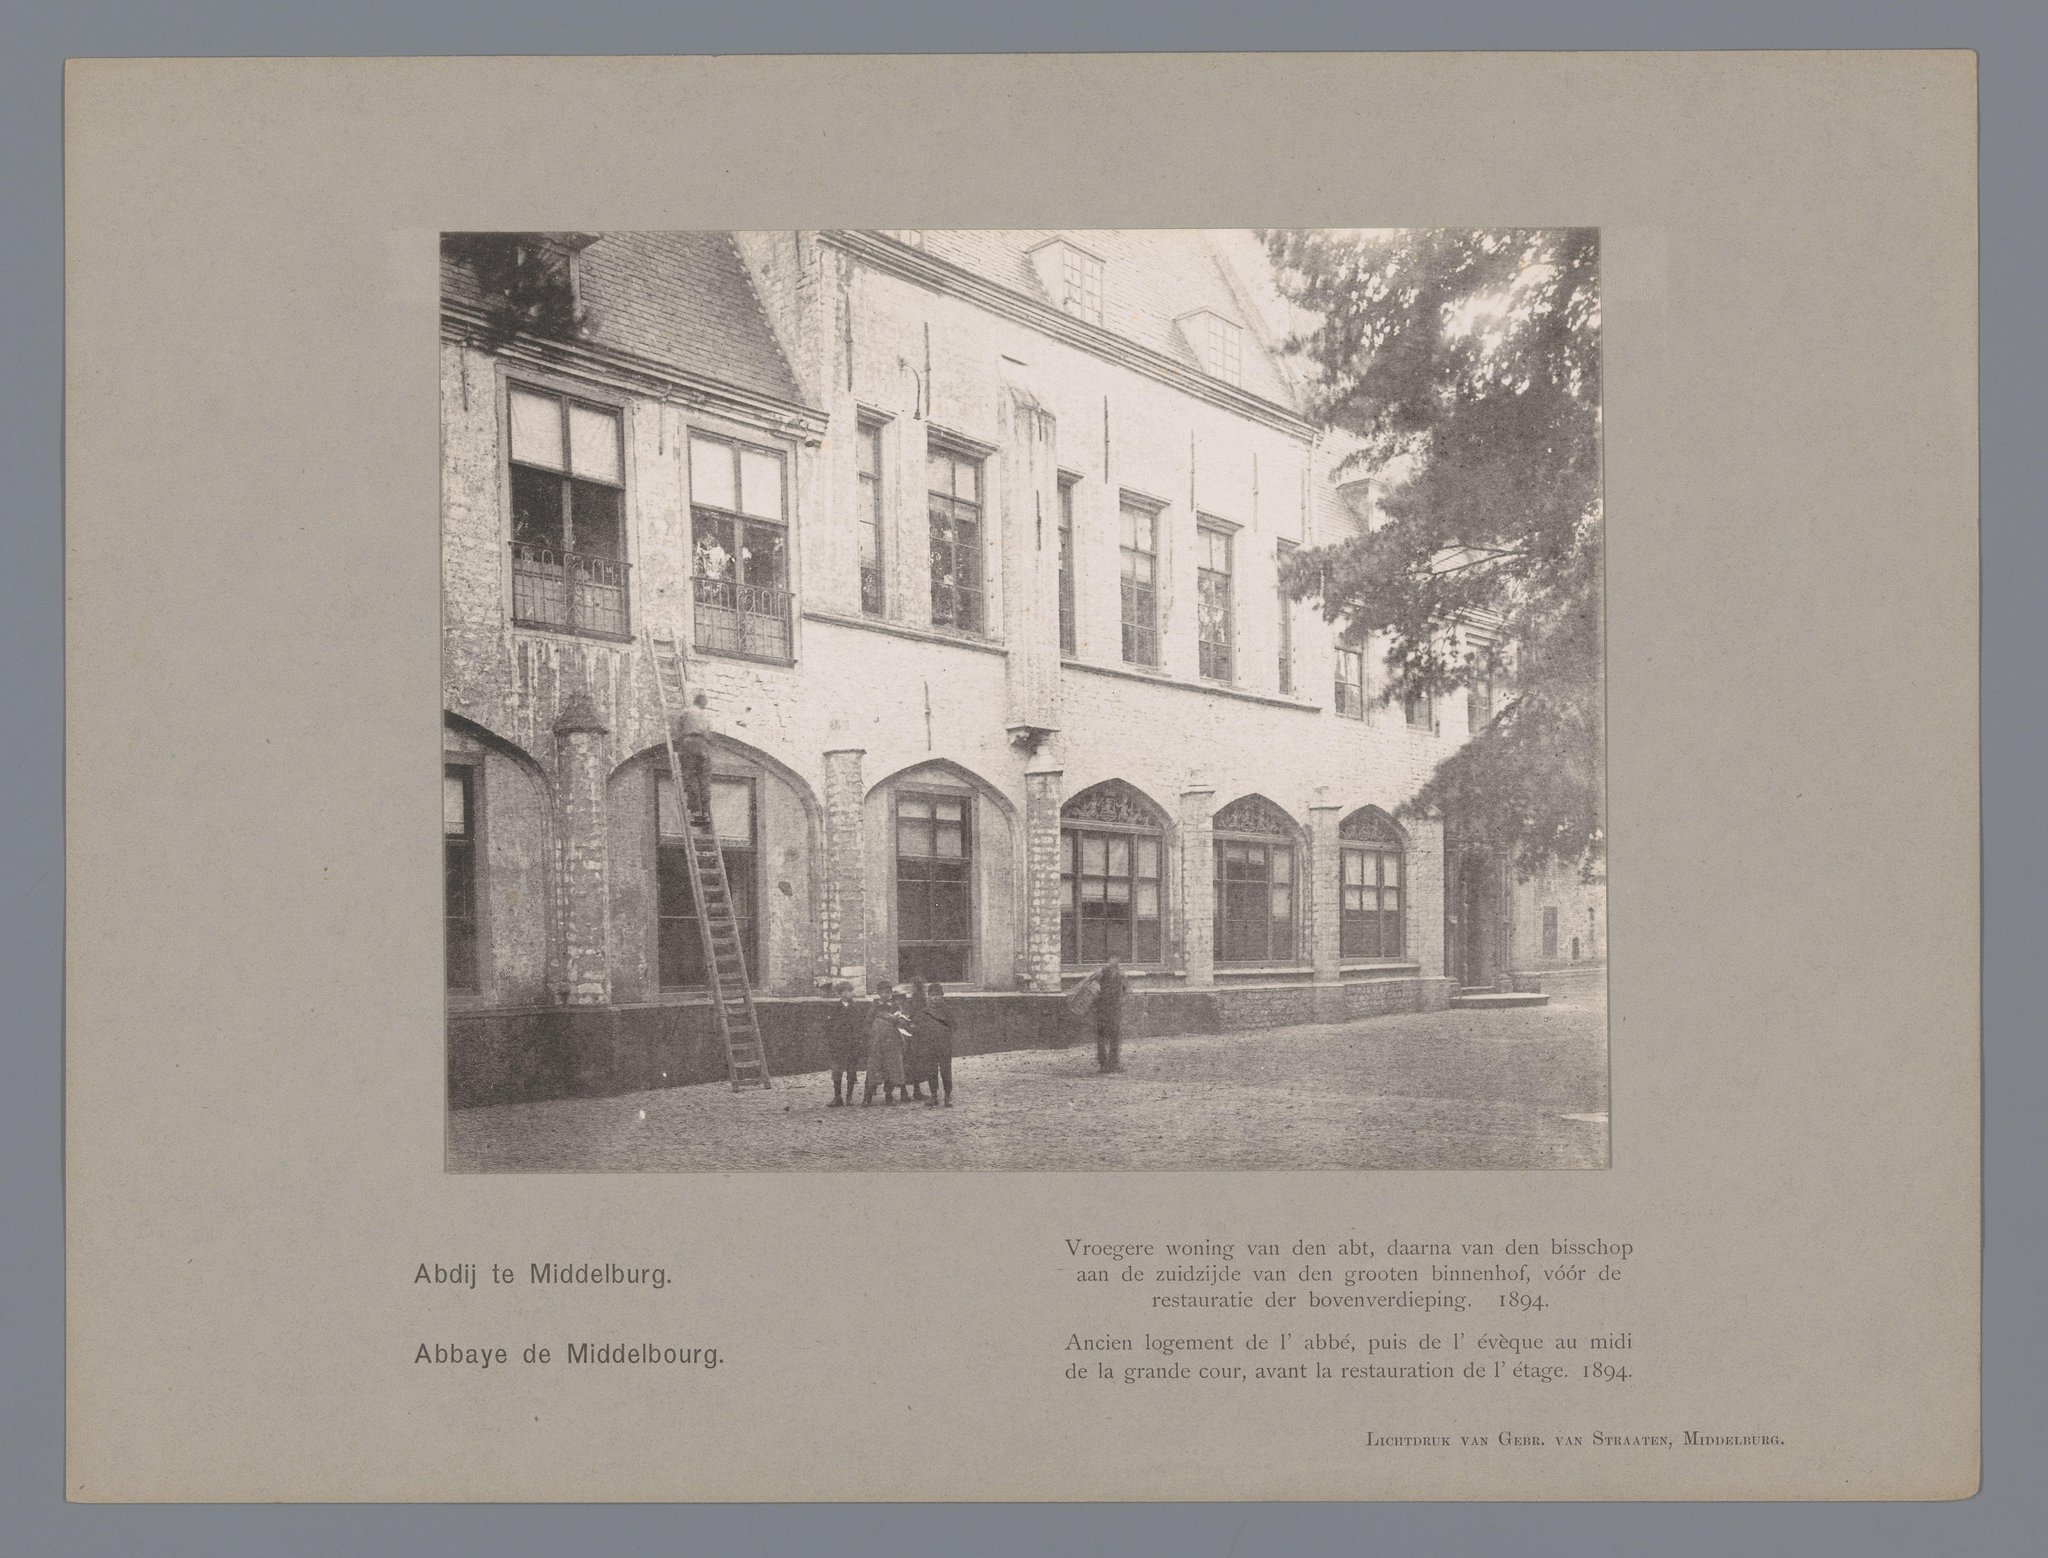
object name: photomechanical print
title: Gezichten op de Abdij te Middelburg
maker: Anonymous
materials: paper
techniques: photograph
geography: middelburg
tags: abbey, monastery, convent ~ roman catholic church, courtyard